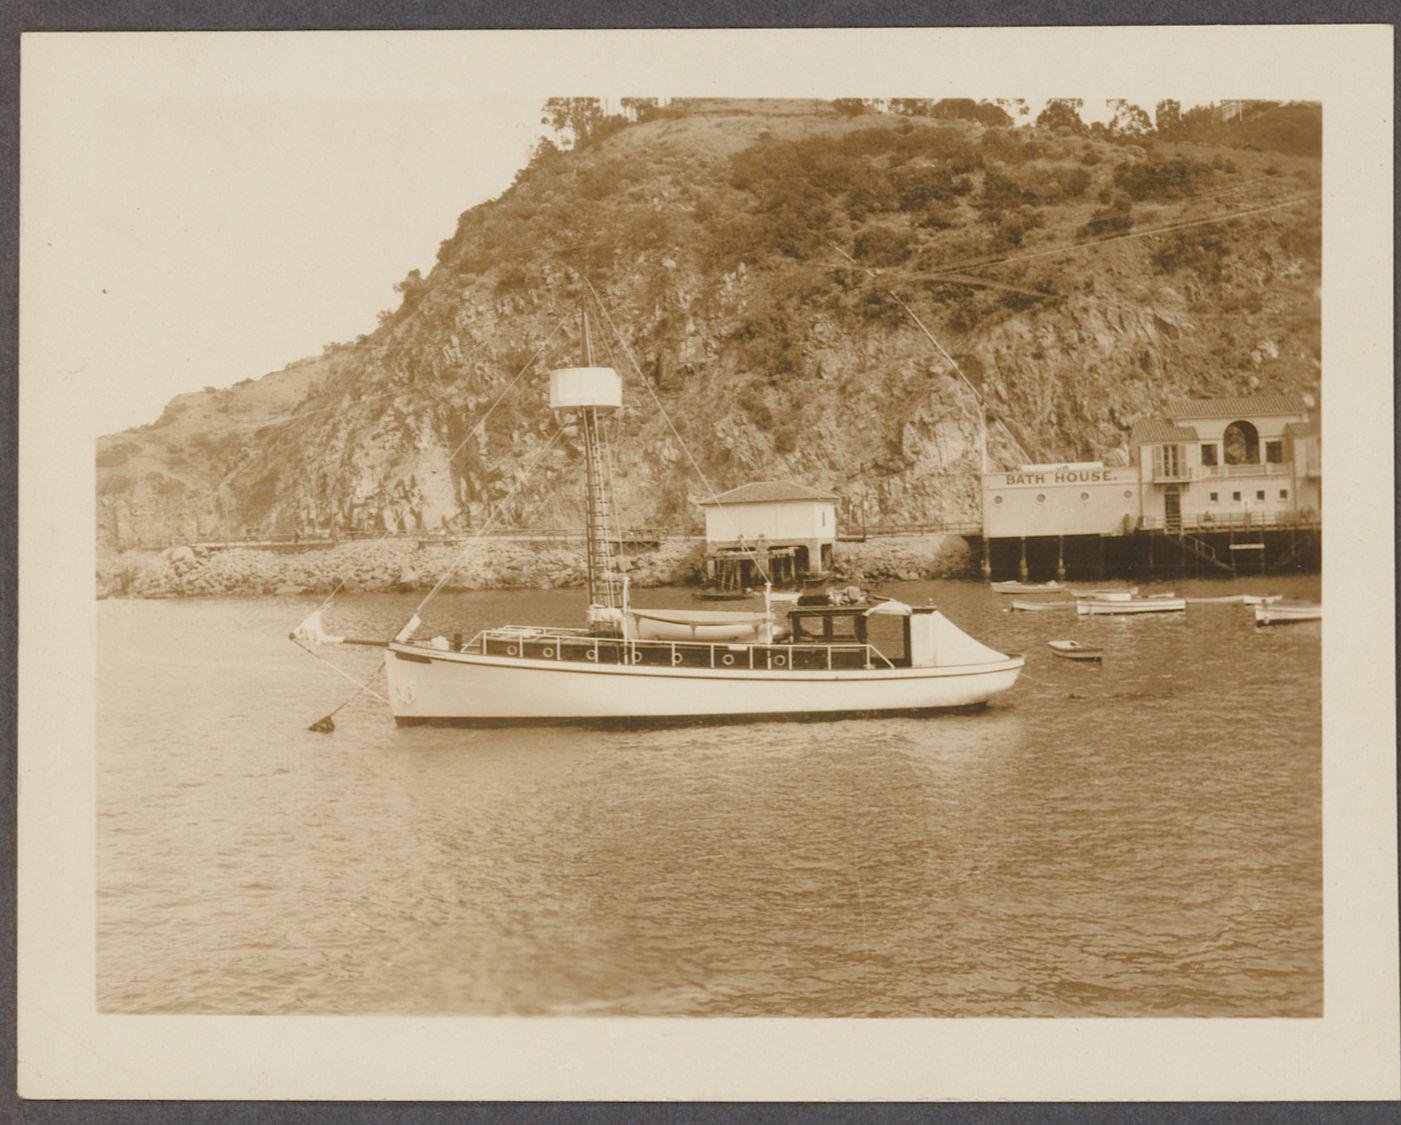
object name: album leaf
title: Zeilschip te water bij Santa Catalina Island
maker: Anonymous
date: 1928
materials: photographic support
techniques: gelatin silver print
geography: santa catalina island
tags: island, sailing-ship, sailing-boat, landscapes with waters, waterscapes, seascapes (in the temperate zone)